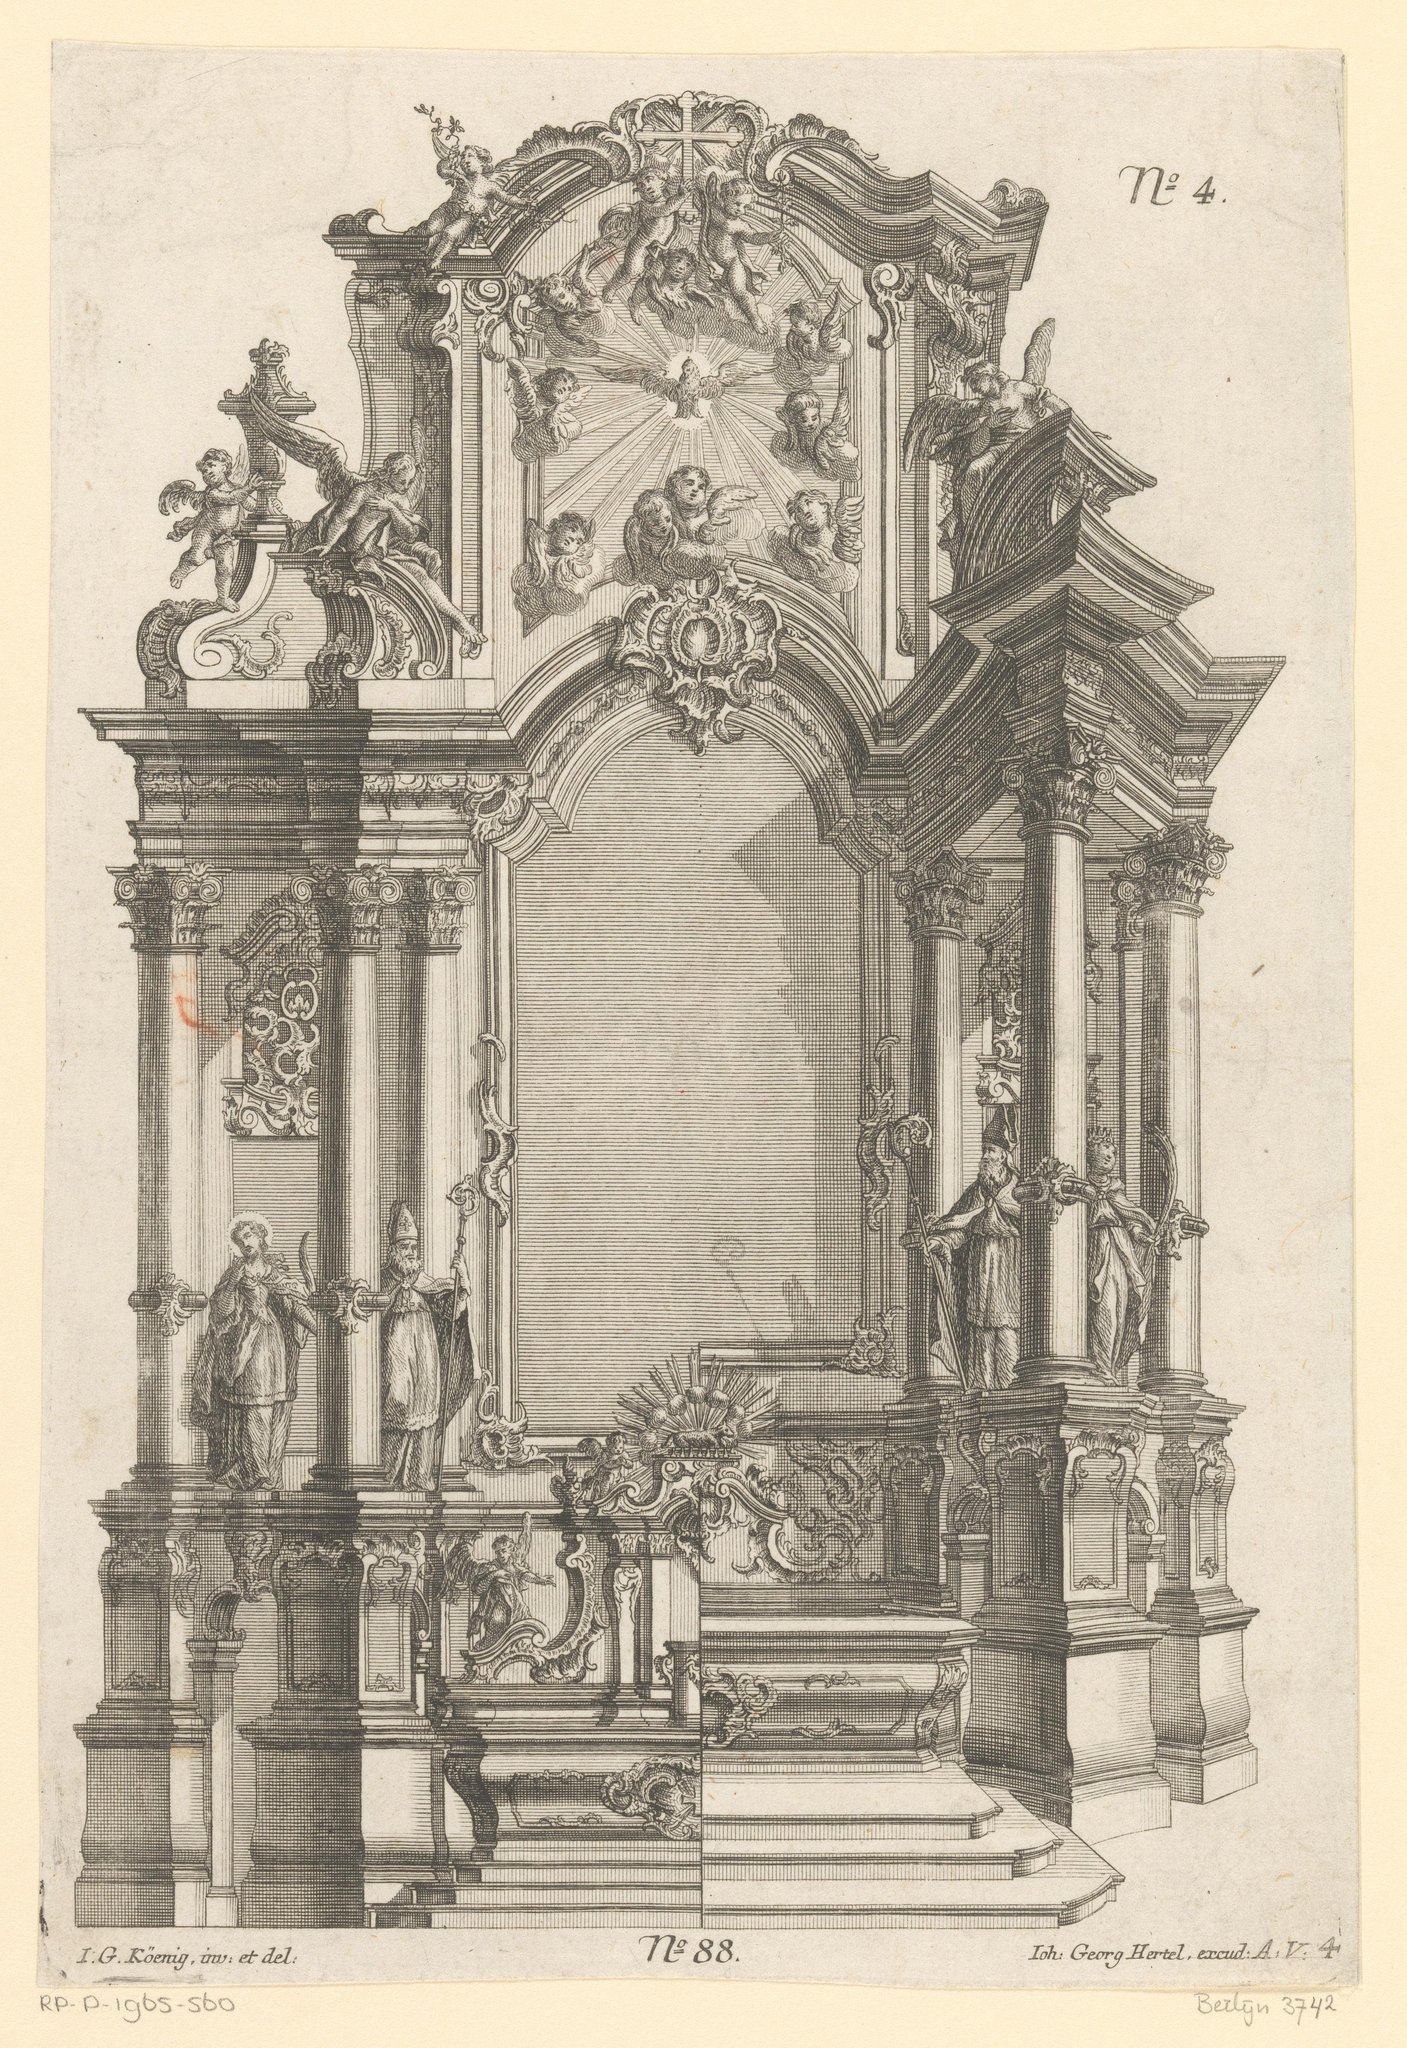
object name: print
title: Altaren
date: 1747-1780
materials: paper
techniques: engraving, etching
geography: augsburg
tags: the vision of the lamb and the book with the seven seals, altar, holy ghost represented as a dove (in flames)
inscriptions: collector's mark: Lugt 2228, collector's mark: Lugt 2760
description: Ontwerp voor een altaar met rocaille ornamenten. Op het altaar ligt het lam met het boek met de zeven zegels, omgeven door een stralenkrans. Aan weerszijden van het altaar staan vier heiligenbeelden. Aan de bovenzijde omgeven engelen en putti een duif in stralenkrans als symbool van de Heilige Geest. Uitgeversnummer 88.